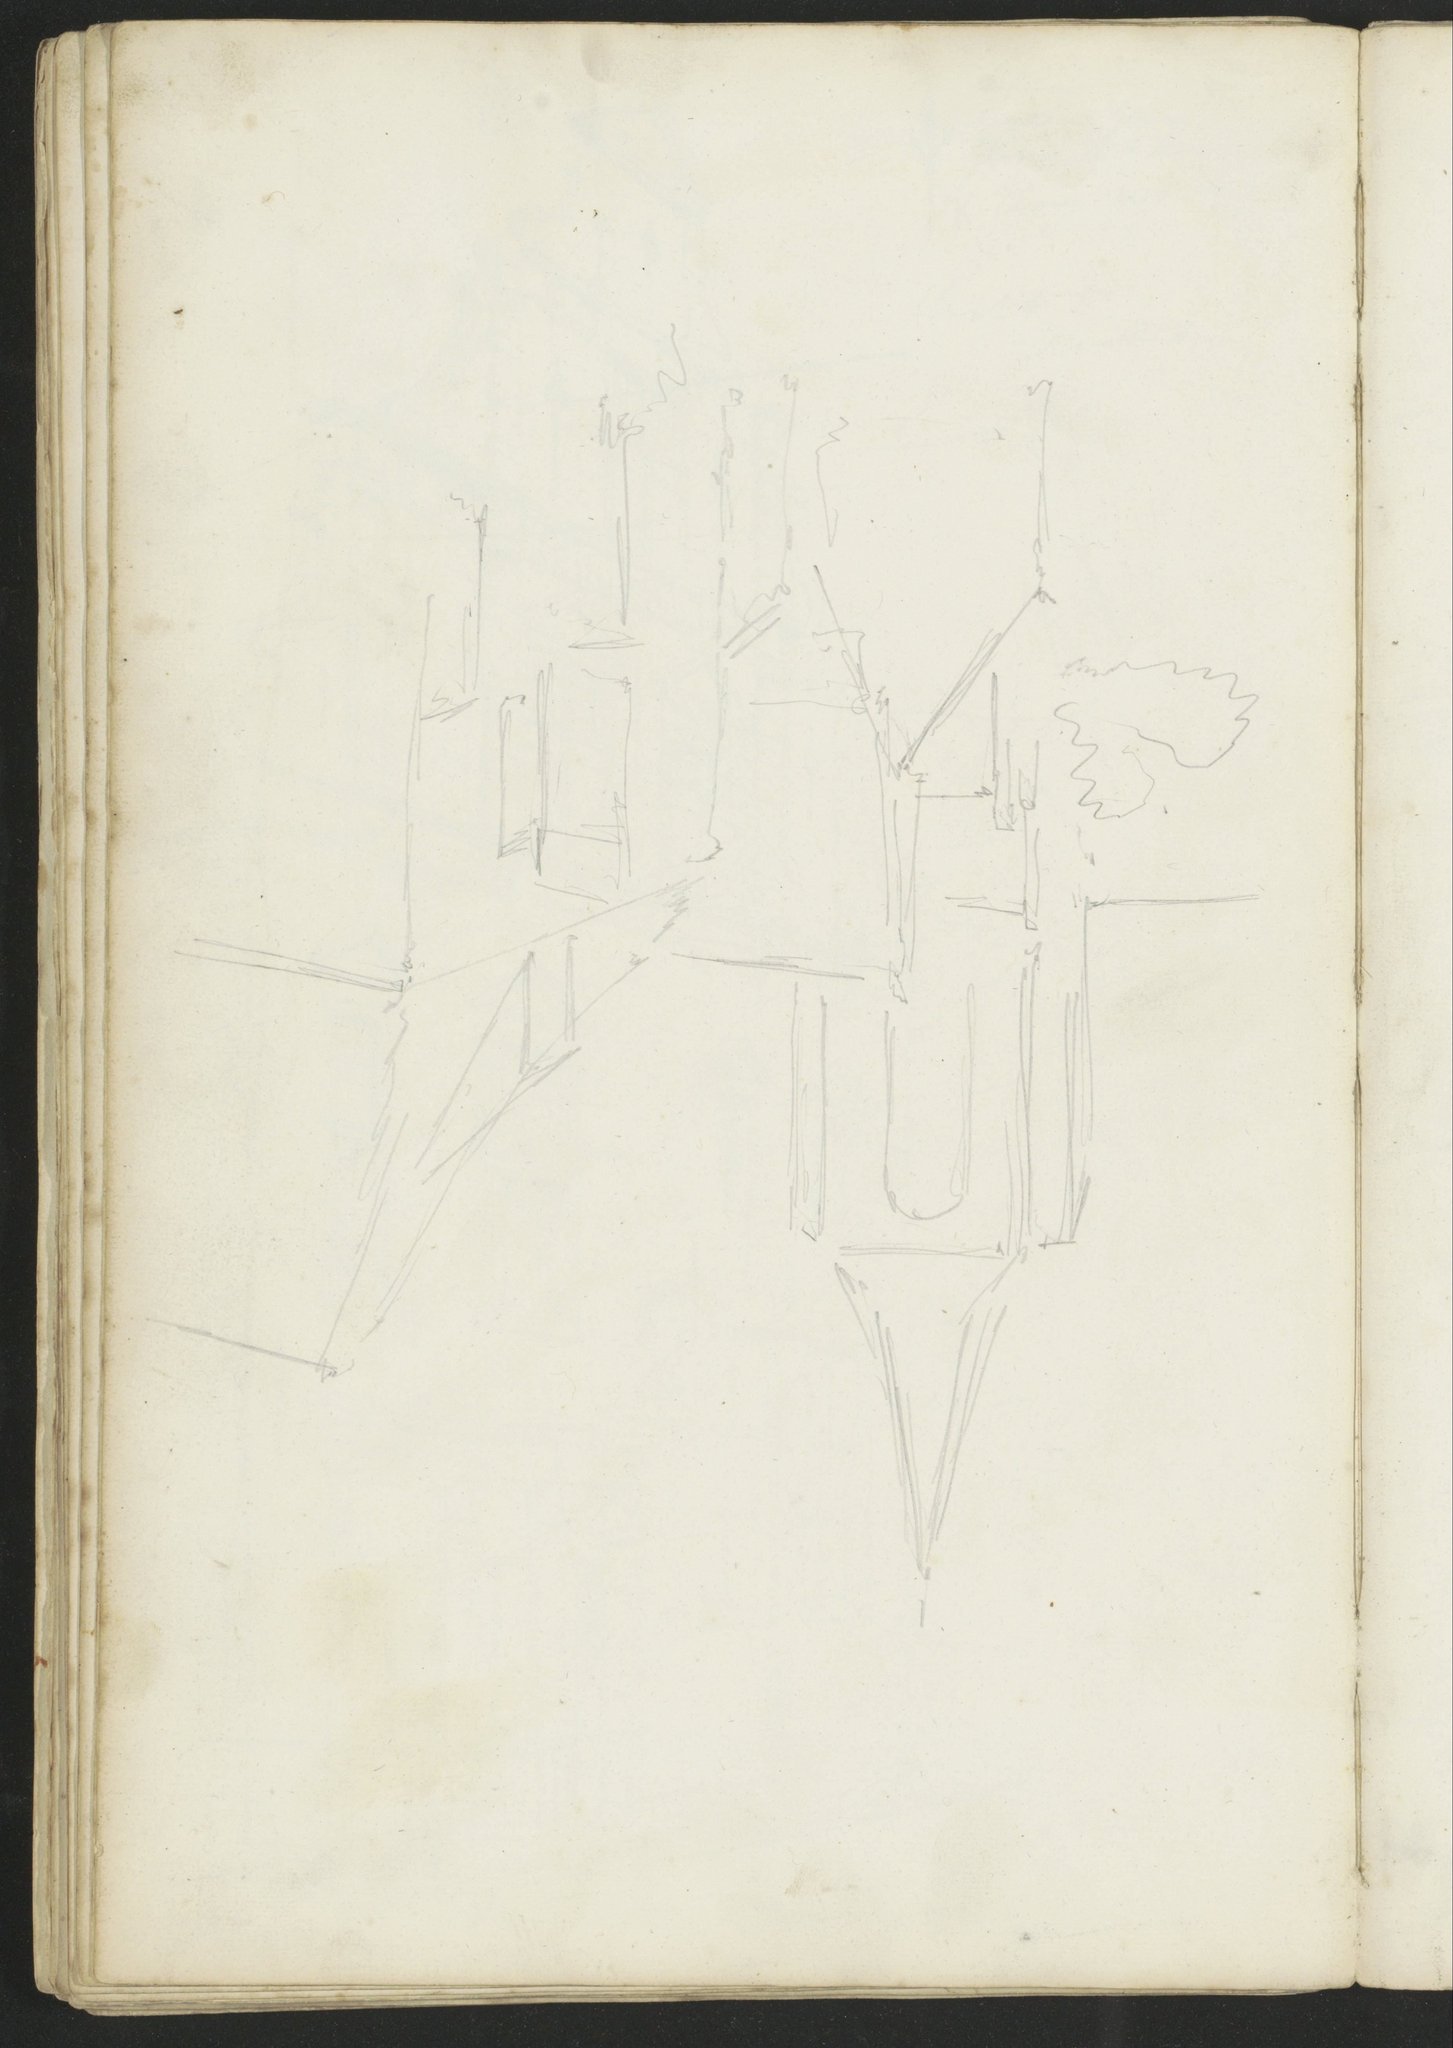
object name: sketchbook leaf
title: Stadsgezicht met kerktoren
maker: willem koekkoek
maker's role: draughtsman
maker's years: 1839-1895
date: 1849-1895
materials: paper, pencil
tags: city-view, and landscape with man-made constructions, parts of church exterior and annexes: tower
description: Blad 36 verso uit een schetsboek met 42 bladen.